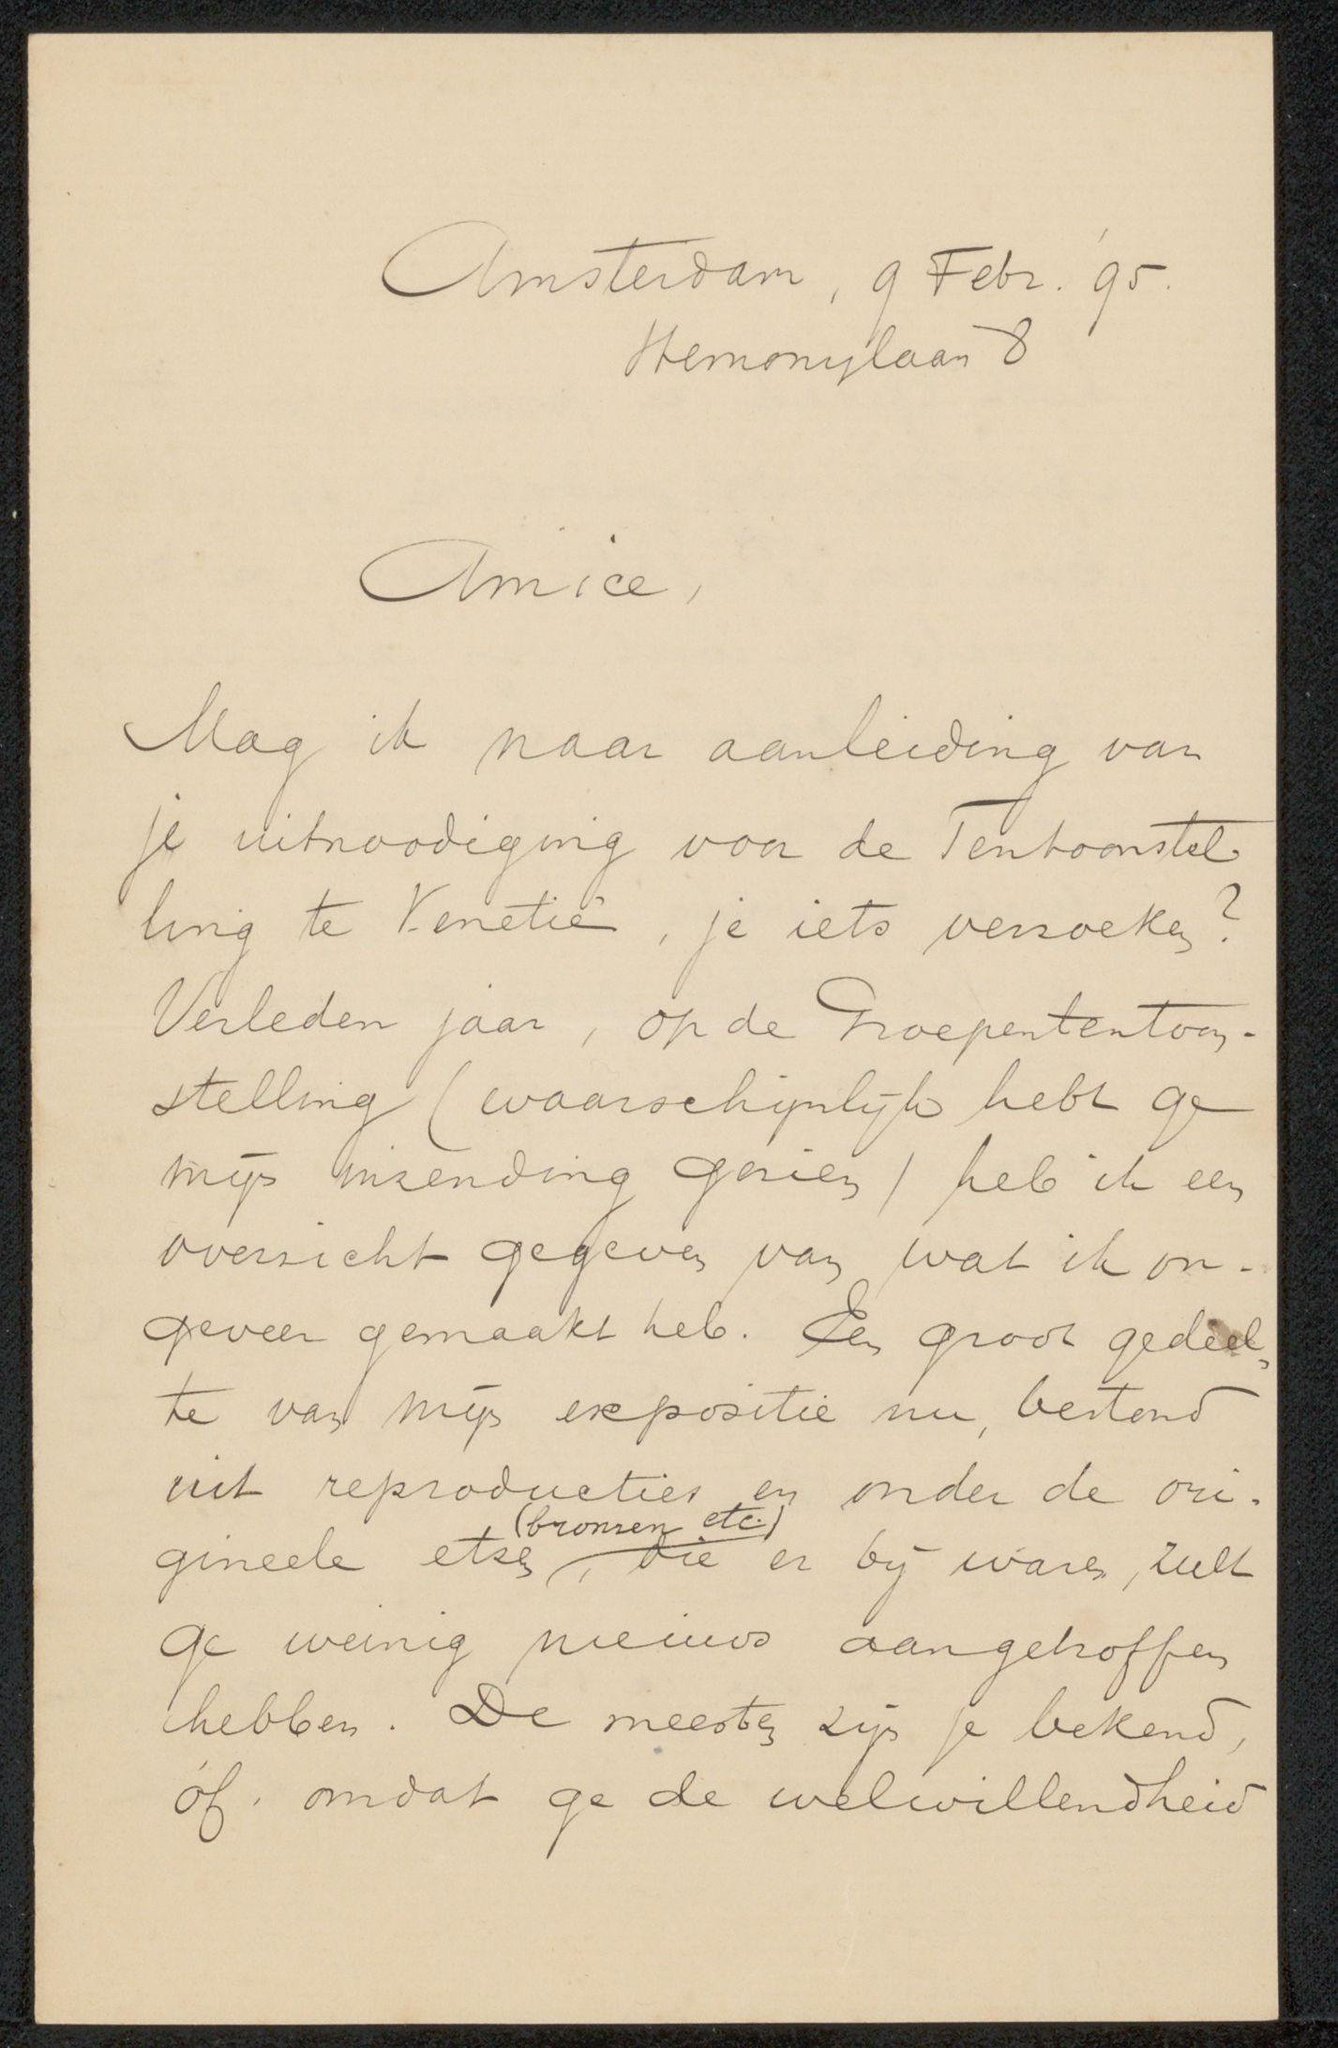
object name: letter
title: Brief aan Philip Zilcken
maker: albrecht felix reicher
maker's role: print maker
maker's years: 1858-1938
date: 1895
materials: ink, paper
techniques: pen, writing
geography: amsterdam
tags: the hague, draughtsman, philip zilcken, the graphic arts, exhibition ~ art, venice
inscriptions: watermark, collector's mark: ‘RPK’